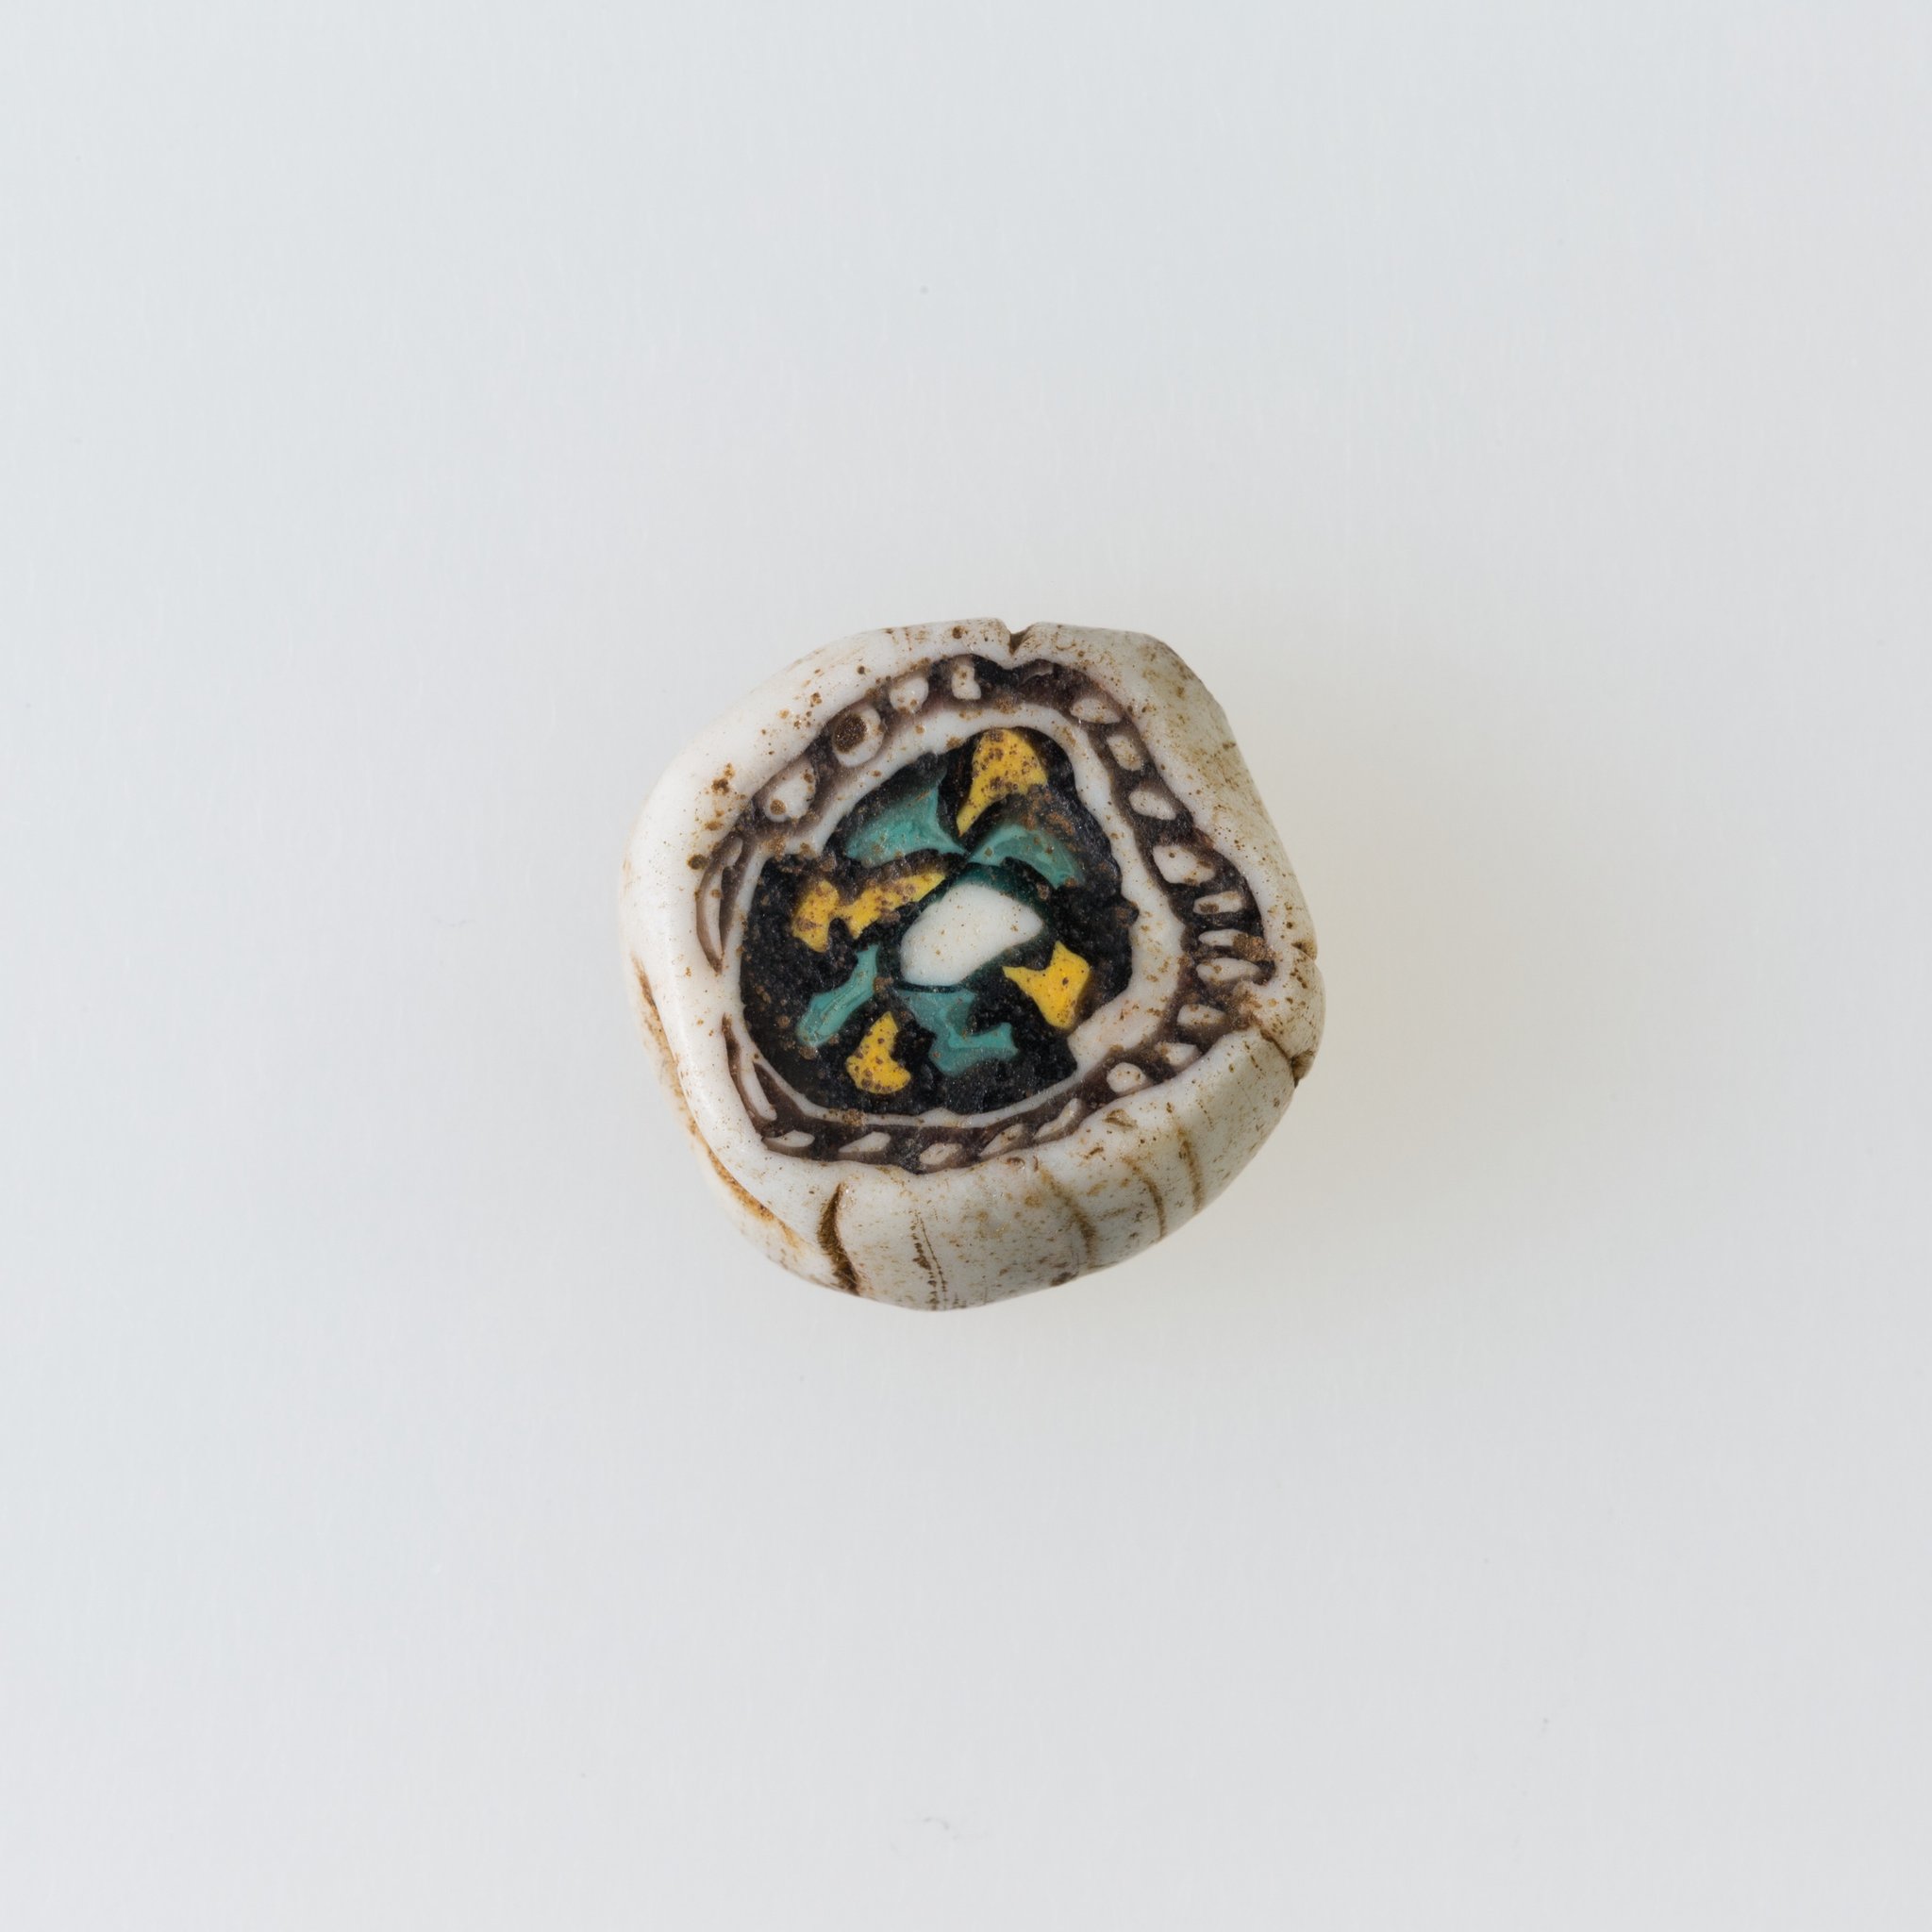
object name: inlay, circular floral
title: Inlay / bead blank, floral design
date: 100 BCE-100 CE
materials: glass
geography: egypt